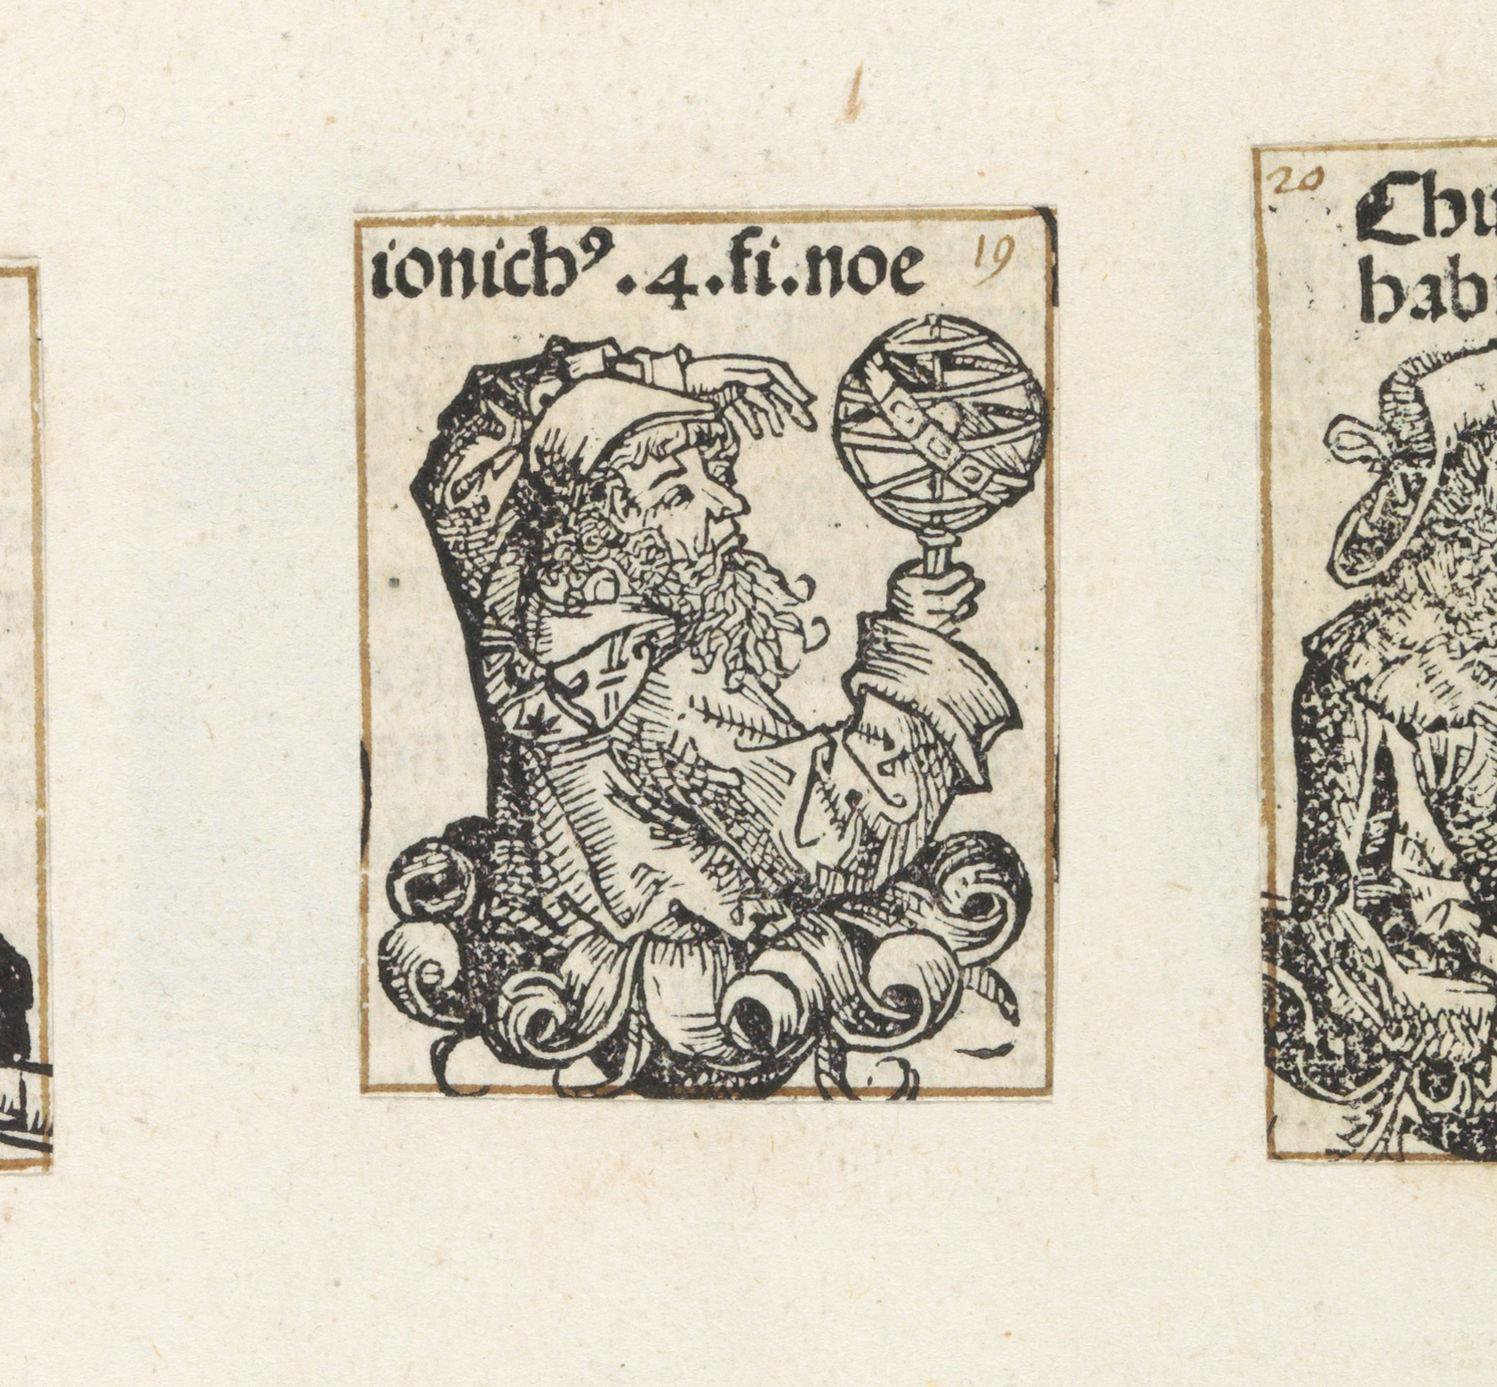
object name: print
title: Liber Chronicarum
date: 1493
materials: paper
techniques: letterpress printing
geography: nuremberg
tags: armillary sphere, skeleton celestial globe, persons from the old testament (not in biblical context, nor occurring in legendary/historical extensions included in division 71)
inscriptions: inscription: ‘19’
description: Een bloemkelk met een man die een armillarium in zijn rechterhand vast heeft. De voorstelling is een fragment van de stamboom van Christus in de Liber Chronicarum. De tekst identificeert de man als de vierde zoon van Noach. De prent maakt deel uit van een album.